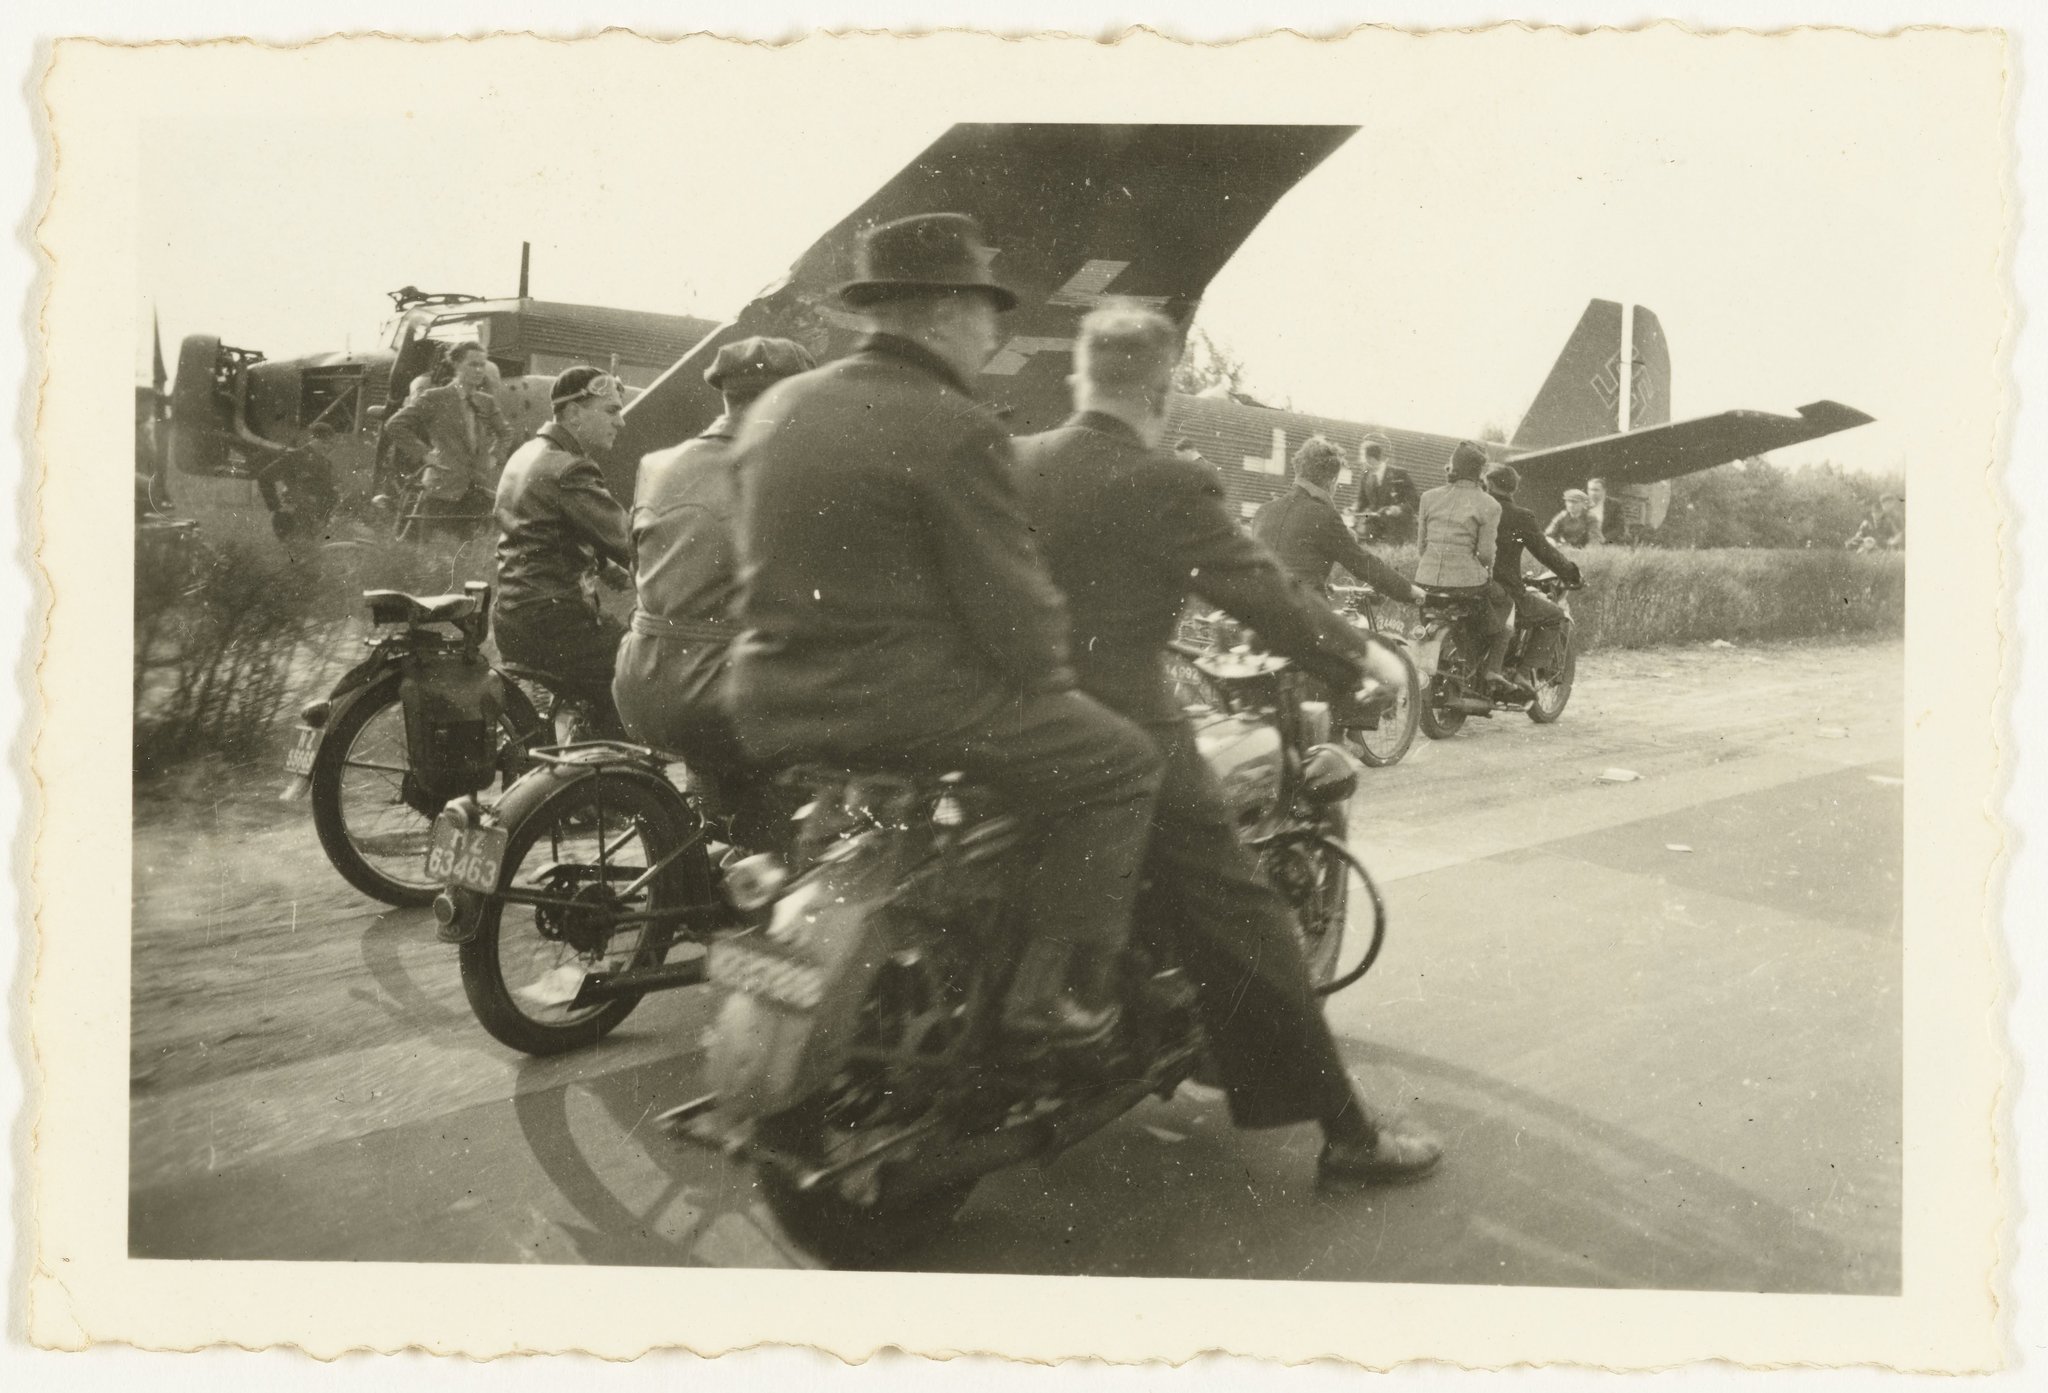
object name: photograph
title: Neergeschoten Duits transportvliegtuig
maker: Anonymous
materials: photographic support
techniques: gelatin silver print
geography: netherlands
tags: motor-cycles and other two-wheeled motor-vehicles, aircraft, aeroplane (+ accident, collision, crash ~traffic and transport), netherlands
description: Langs de kant van een autoweg liggen twee neergeschoten Duitse gevechtsvliegtuigen, een is een Junker 52. Nederlanders op motorfietsen komen de wrakken bekijken. Foto dateert vermoedelijk uit de meidagen 1940.